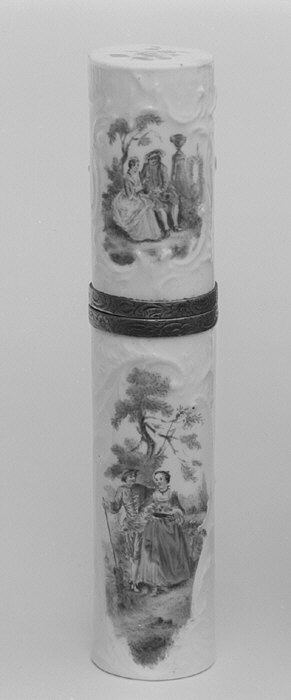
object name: étui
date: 1734-1766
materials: hard paste porcelain, silver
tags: men,women,trees